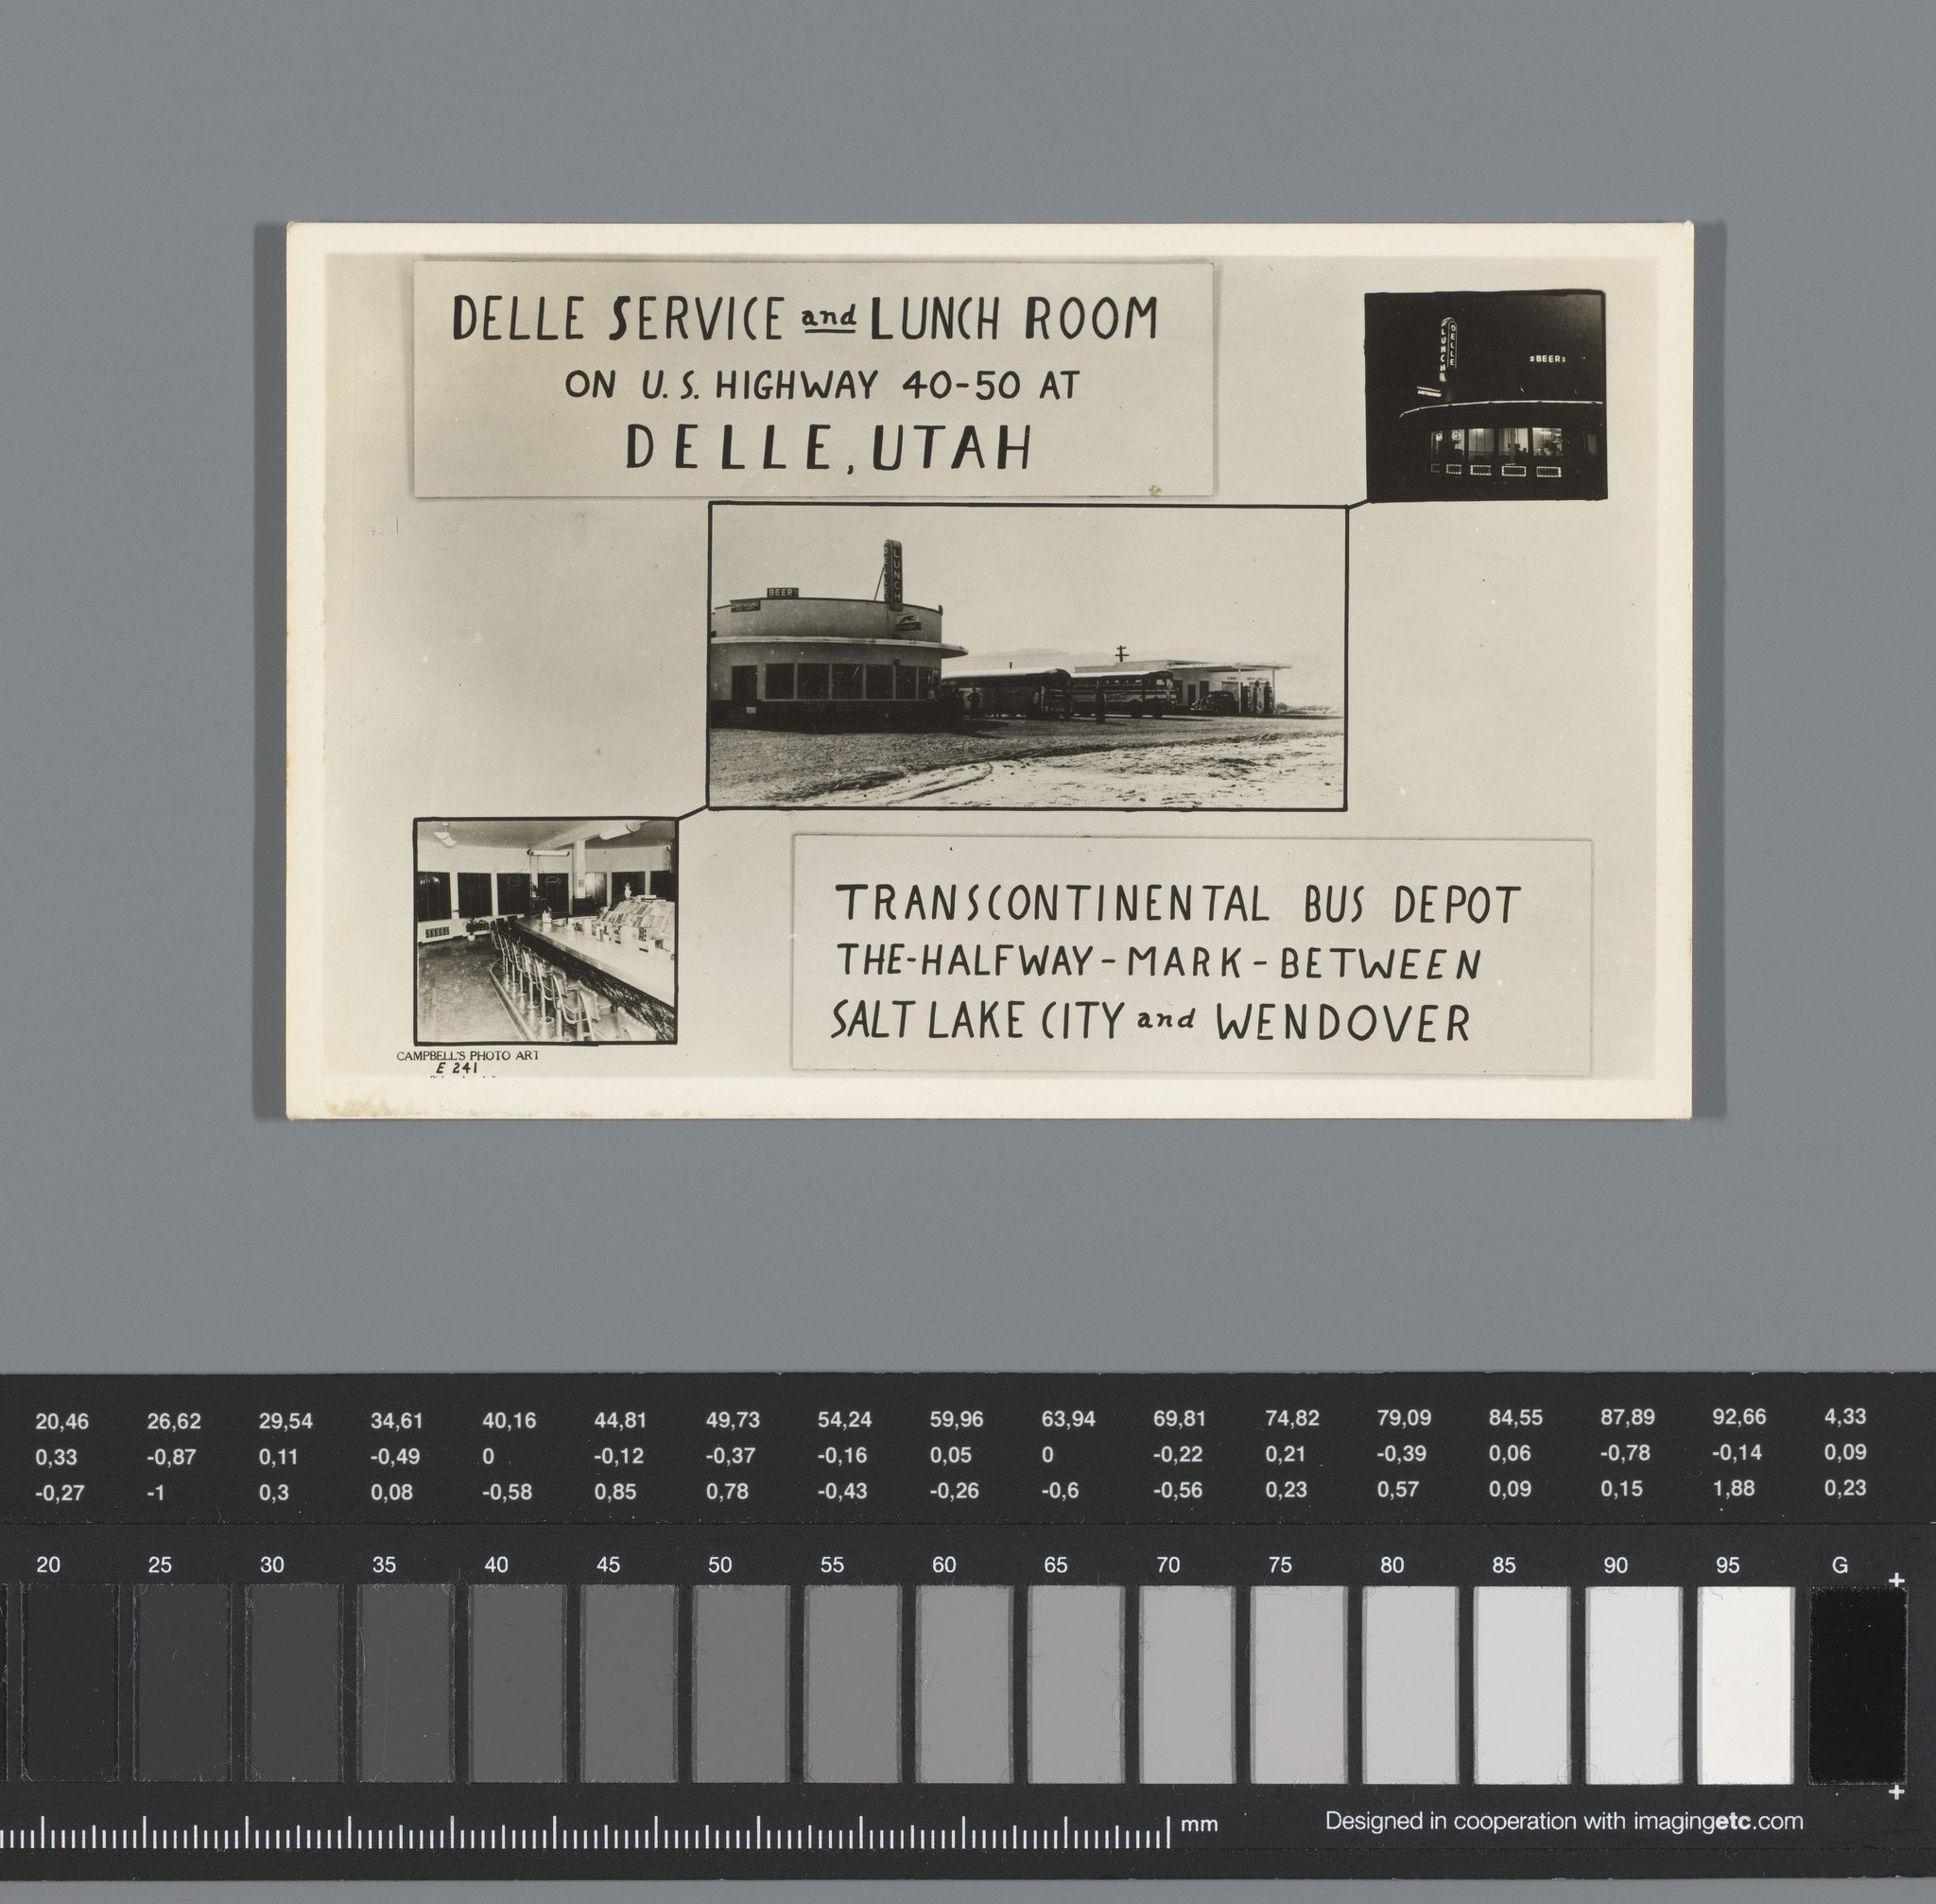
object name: ansichtkaart, prentbriefkaart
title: Reclame voor een busstation en lunchroom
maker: Anonymous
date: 1910-1930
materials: photographic support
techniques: photography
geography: united states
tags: united states of america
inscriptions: inscription: ‘DELLE SERVICE and LUNCH ROOM / ON U. S. HIGHWAY 40-50 AT / DELLE, UTAH / TRANSCONTINENTAL BUS DEPOT / THE-HALFWAY-MARK-BETWEEN / SALT LAKE CITY and WENDOVER’